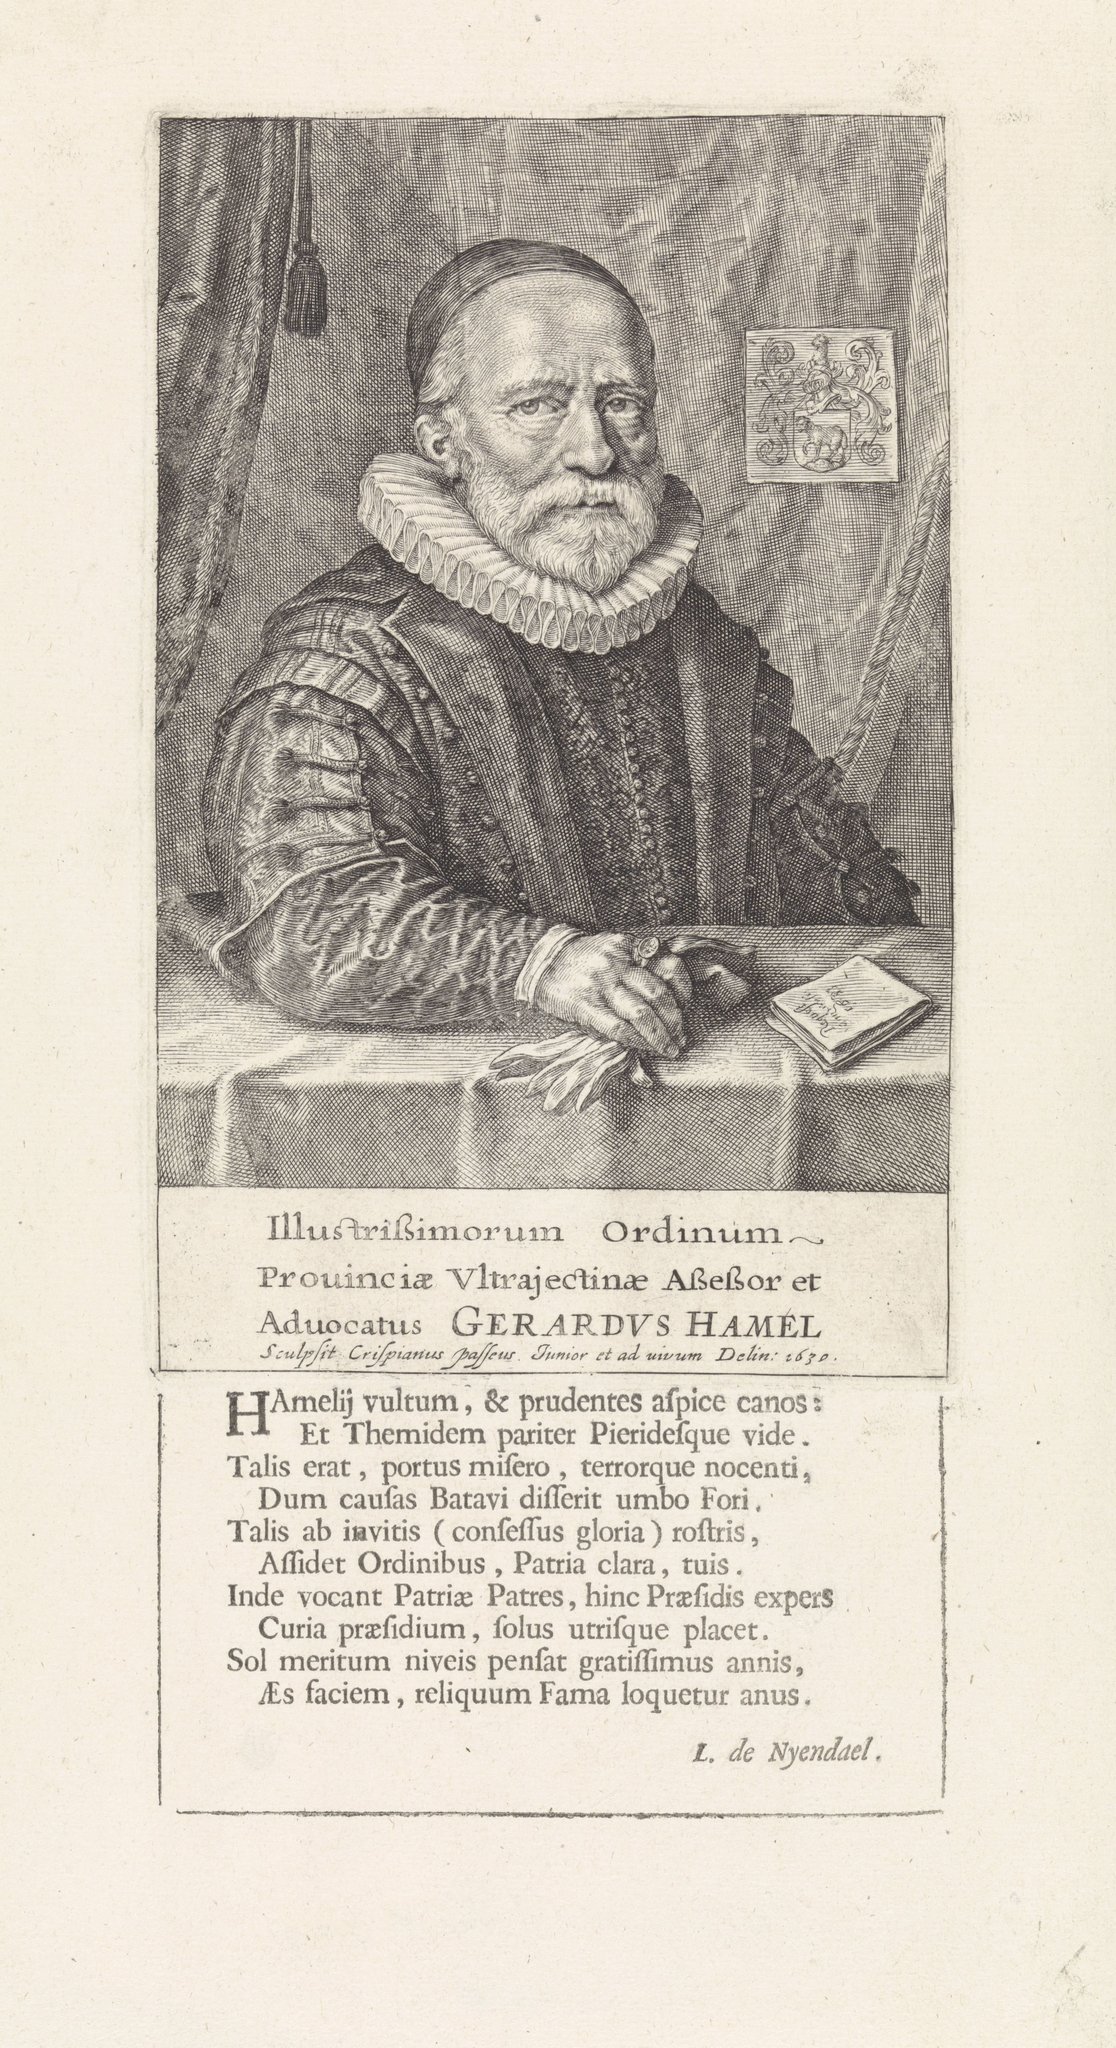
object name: print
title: Portret van Gerard Hamel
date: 1630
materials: paper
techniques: engraving, letterpress printing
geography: utrecht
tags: official; civil servant; functionary (in general), historical persons, armorial bearing, heraldry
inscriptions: collector's mark: Lugt 2228, collector's mark: Lugt 2760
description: Portret van de advocaat Gerard Hamel, met zijn wapenschild. In de marge een drieregelig onderschrift met de naam en functie van de geportretteerde in het Latijn. Daaronder een tienregelig lofdicht in boekdruk in het Latijn.